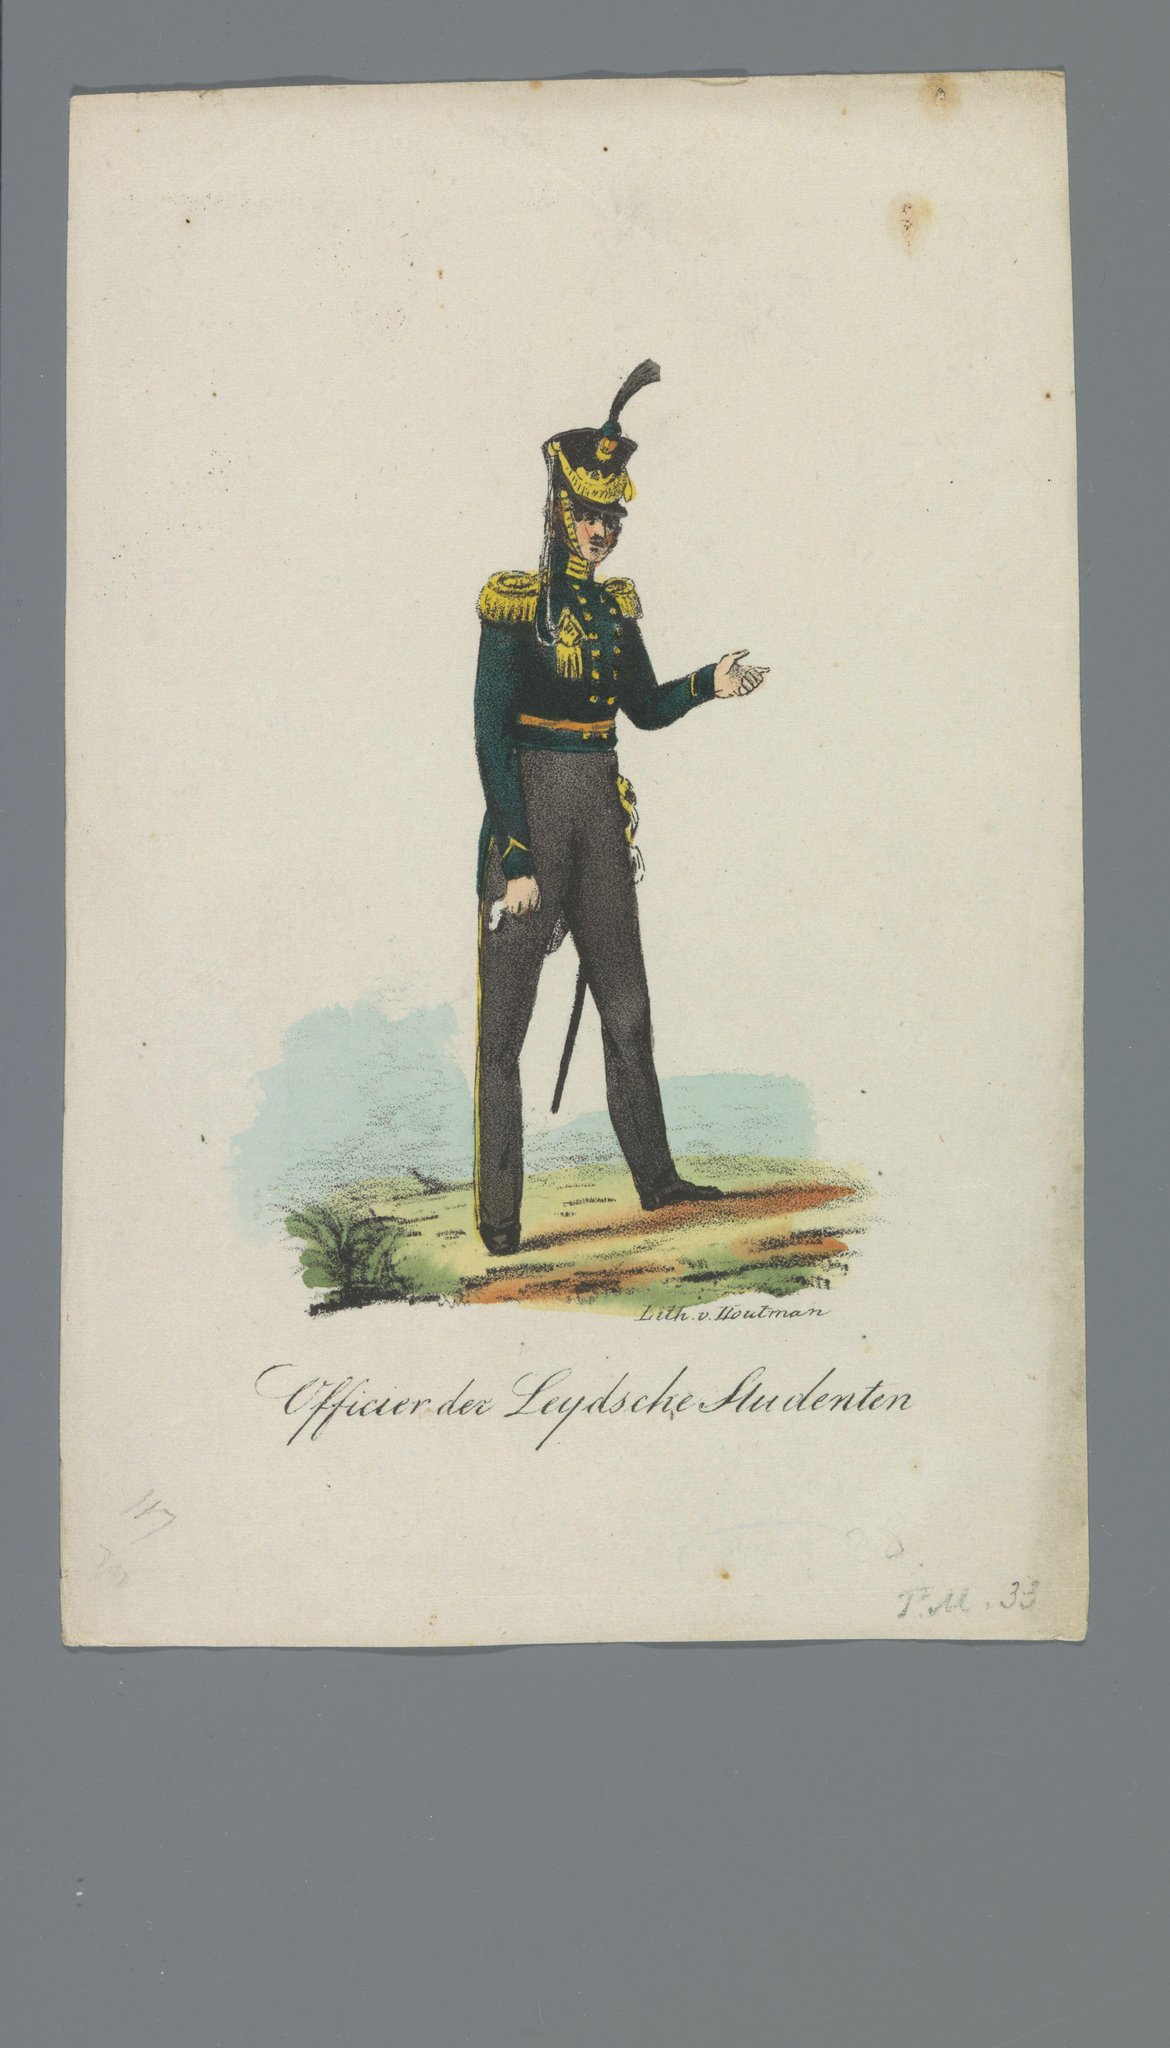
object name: print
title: Nederlandse militaire uniformen in de jaren 1830-1832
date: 1835-1850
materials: paper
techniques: hand coloring, lithograph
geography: utrecht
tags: clothes, costume (+ men's clothes), (military) uniforms, leiden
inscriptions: collector's mark: Lugt 2227, collector's mark: Lugt 2228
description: Staande officier van de Compagnie Vrijwillige Jagers van de Hogeschool te Leiden. Onderdeel van een serie van 156 losse bladen met Nederlandse militaire uniformen in de jaren 1830-1832.